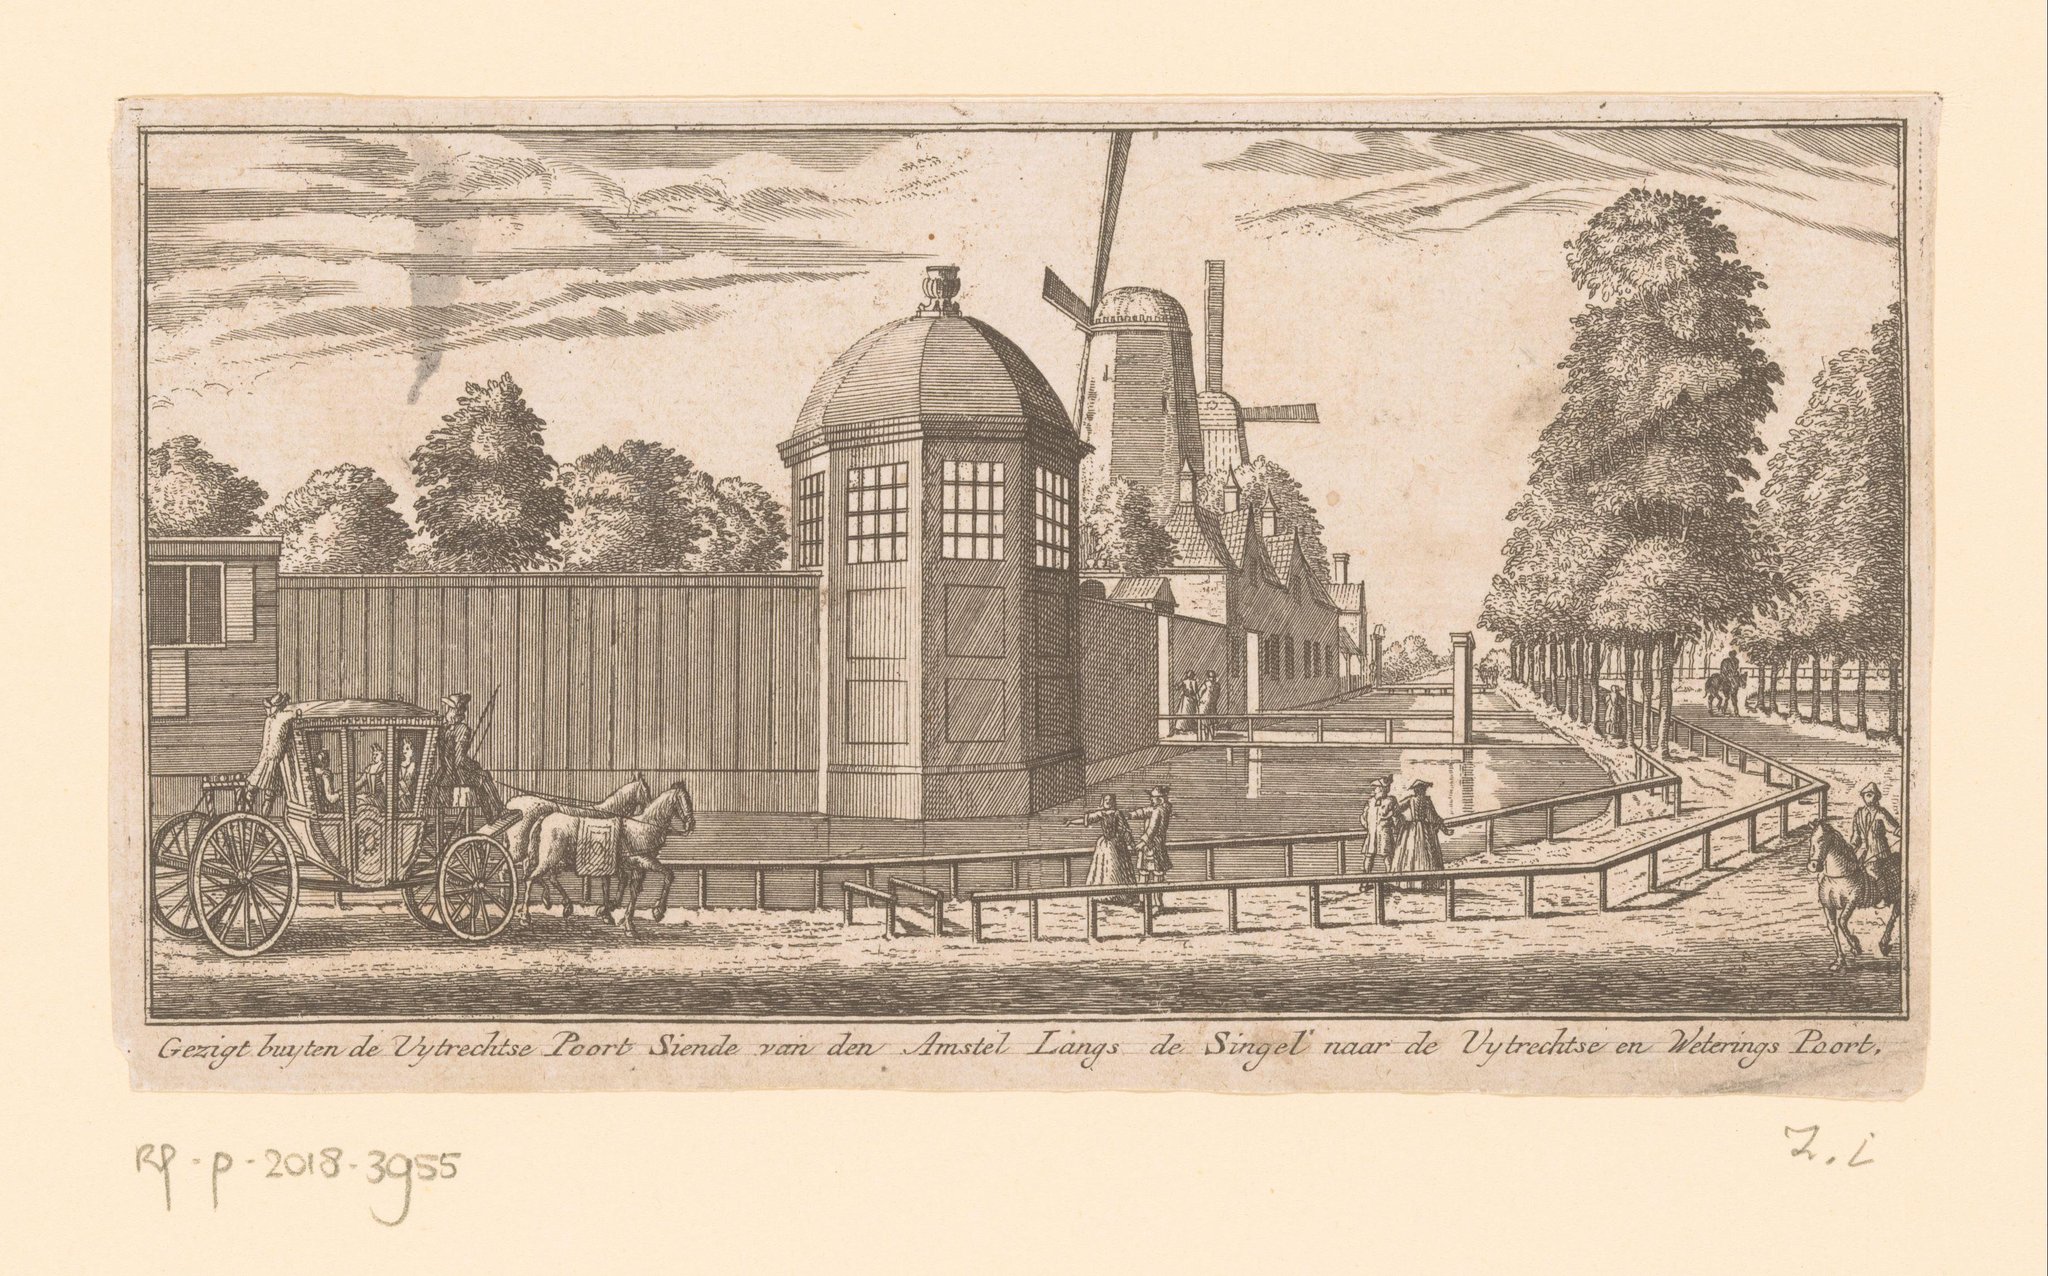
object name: print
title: Gezicht buiten de Utrechtsepoort in Amsterdam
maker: gerardus condet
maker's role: print maker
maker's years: 1715-1764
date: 1725-1764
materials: paper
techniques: engraving, etching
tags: bridge in city across river, canal, etc., four-wheeled vehicle drawn by two animals, walking arm in arm, city-gate